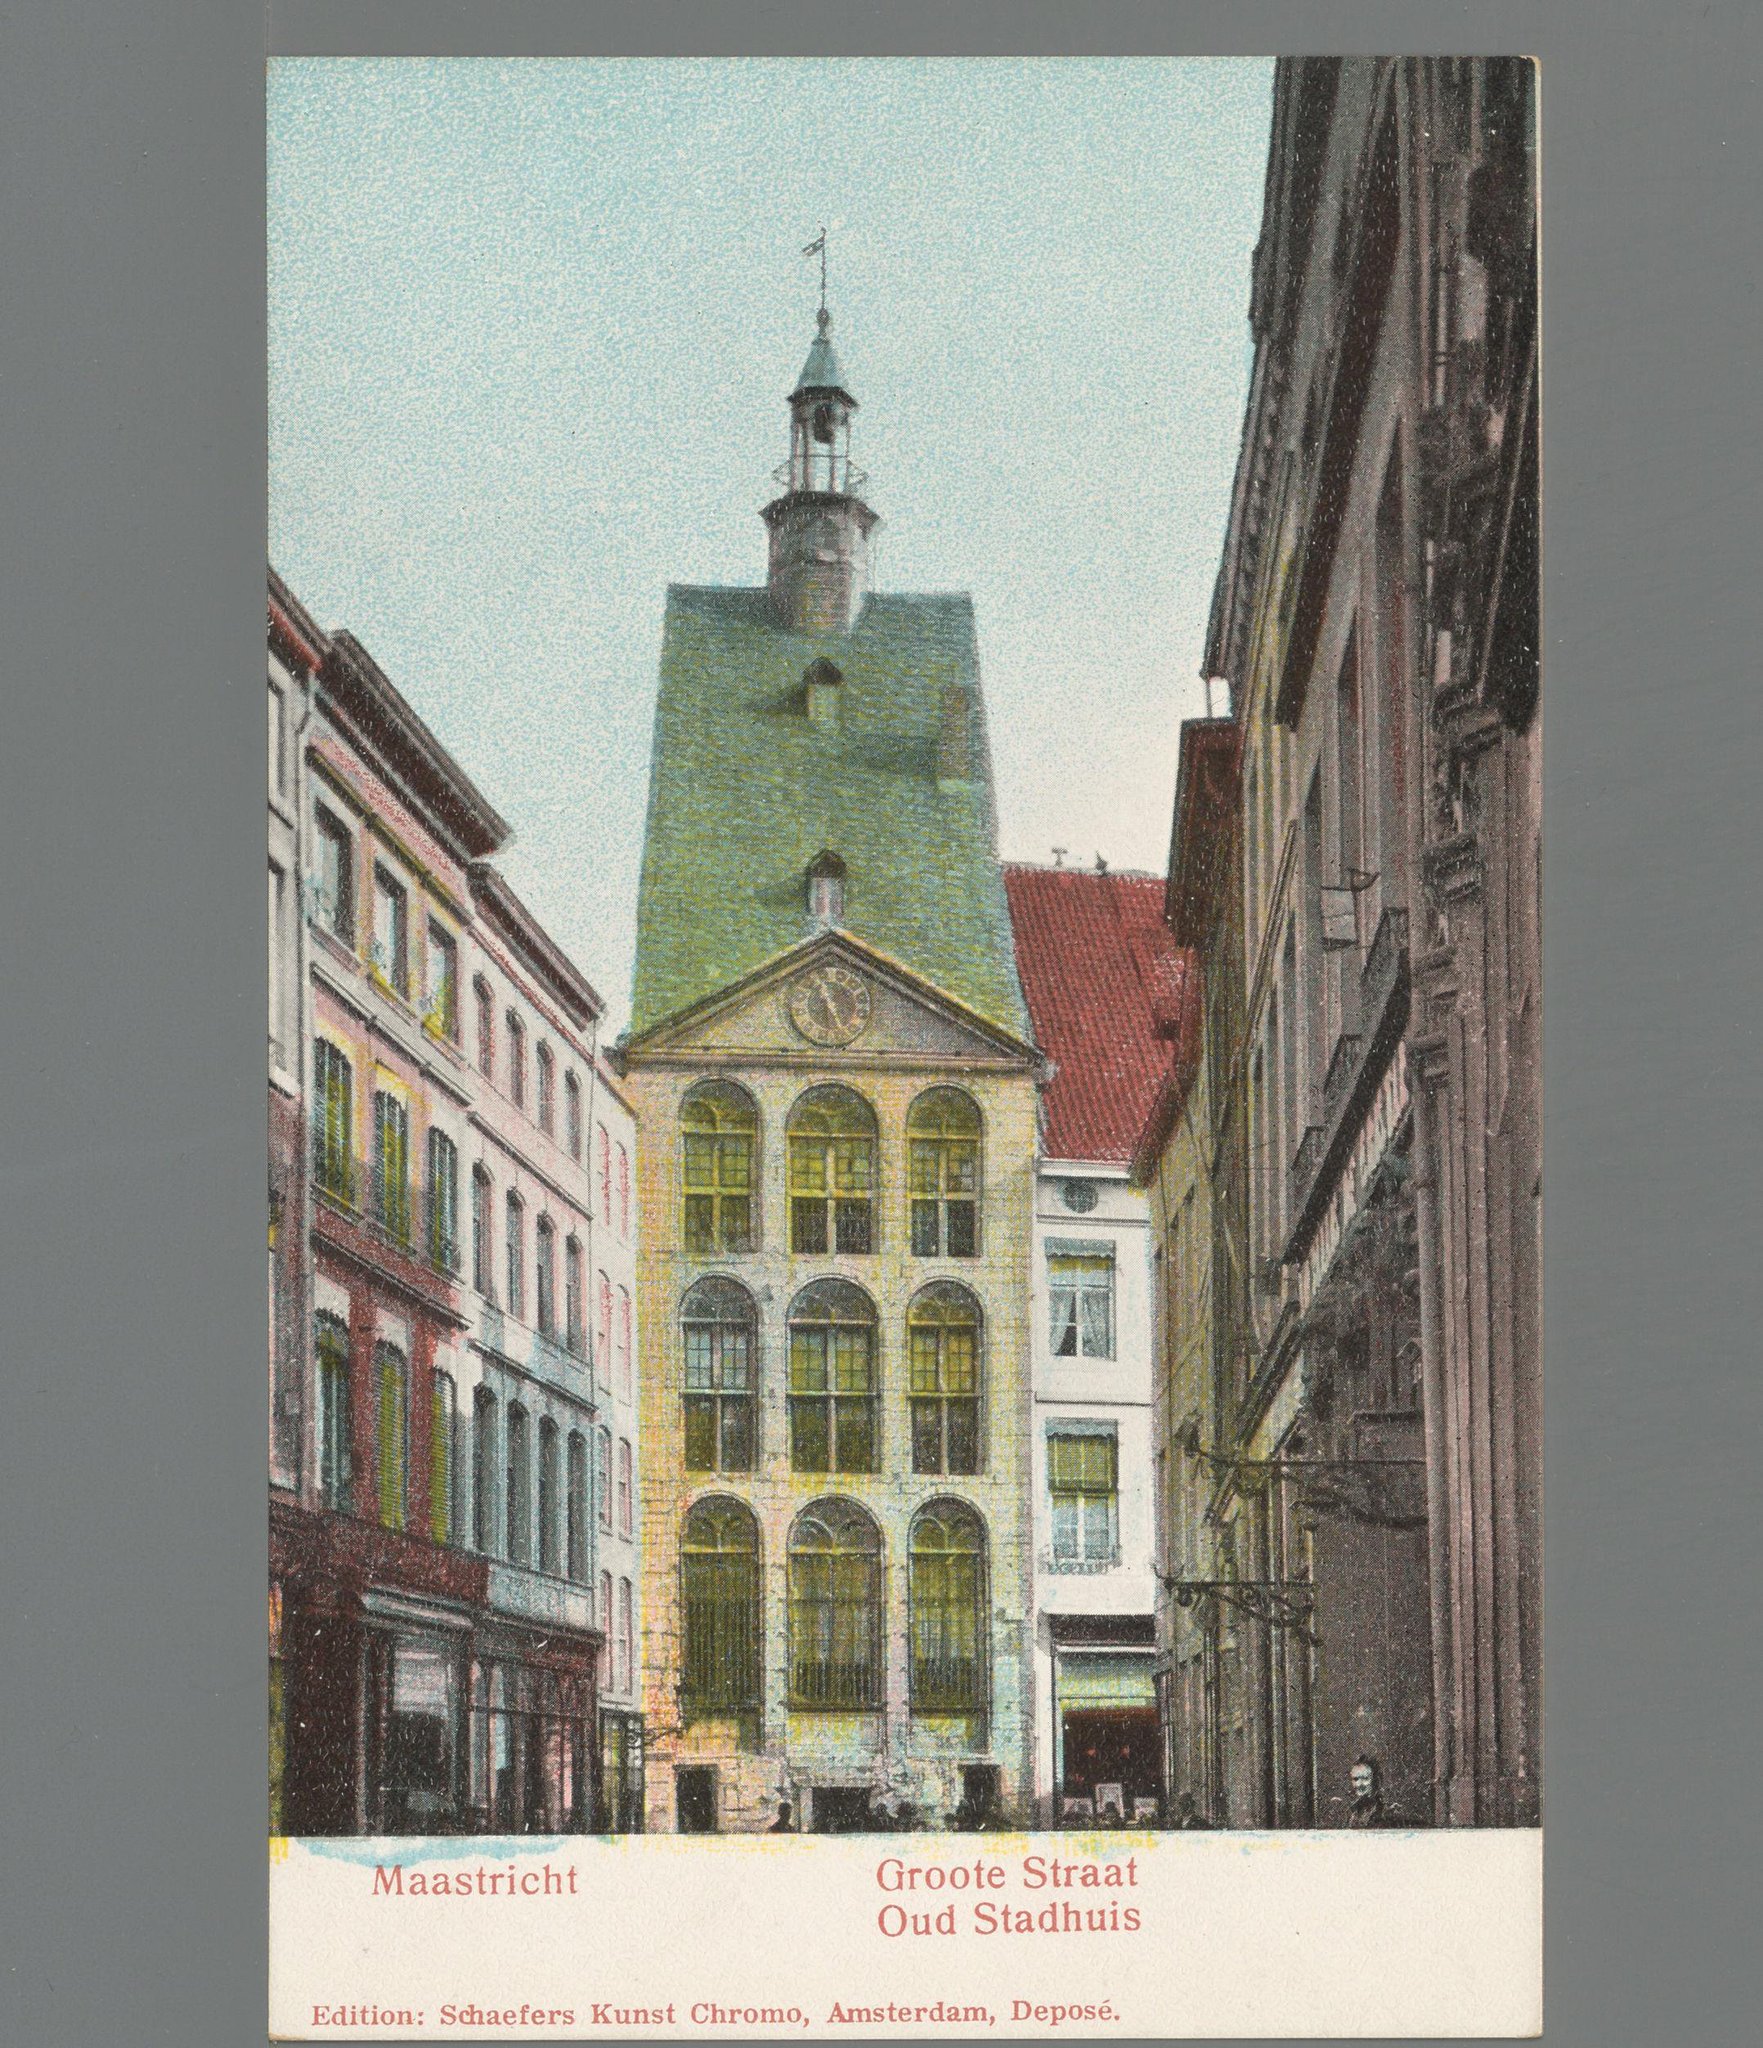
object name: photomechanical print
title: Maastricht. Groote Straat, oud stadhuis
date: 1905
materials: cardboard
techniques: lithograph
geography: amsterdam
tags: townhall, street, maastricht